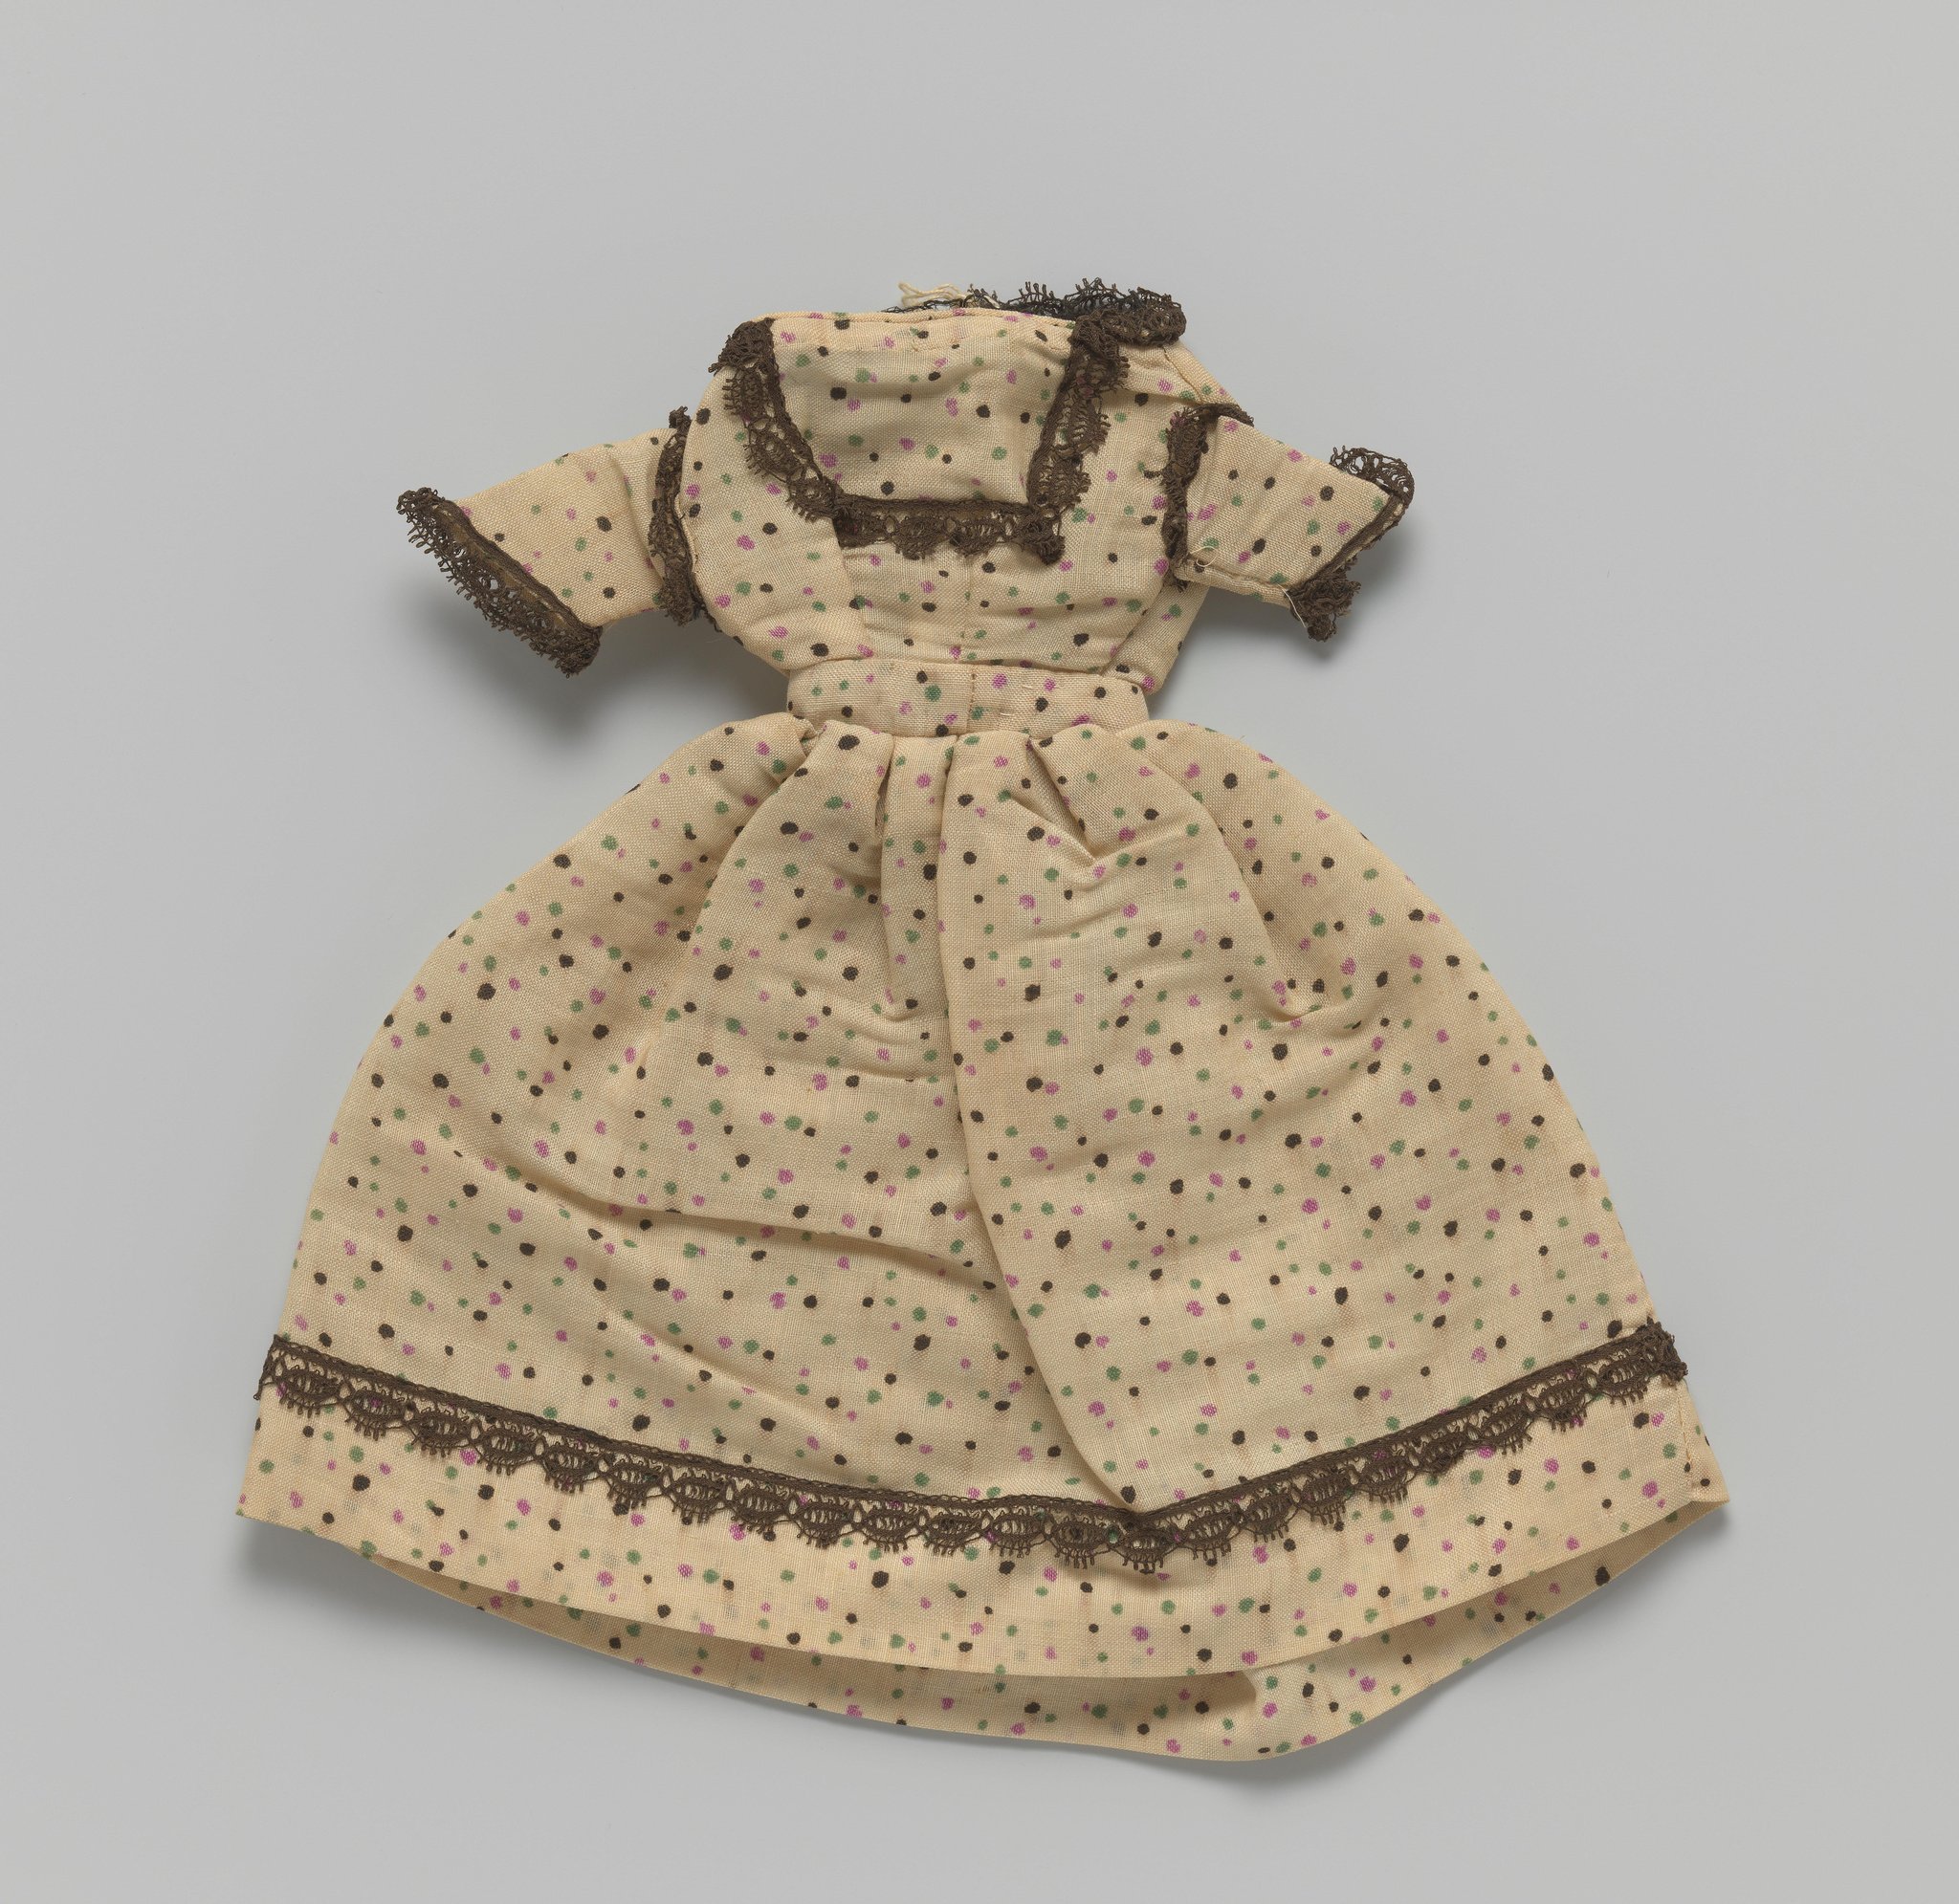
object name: doll's clothing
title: Japon van beige linnen met stippen in roze, groen en zwart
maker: Anonymous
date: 1850-1920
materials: linen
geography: europe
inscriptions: number: ‘RBK15445’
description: Aan de onderzijde en langs de mouwen en de hals is de japon voorzien van bruine stroken kant.